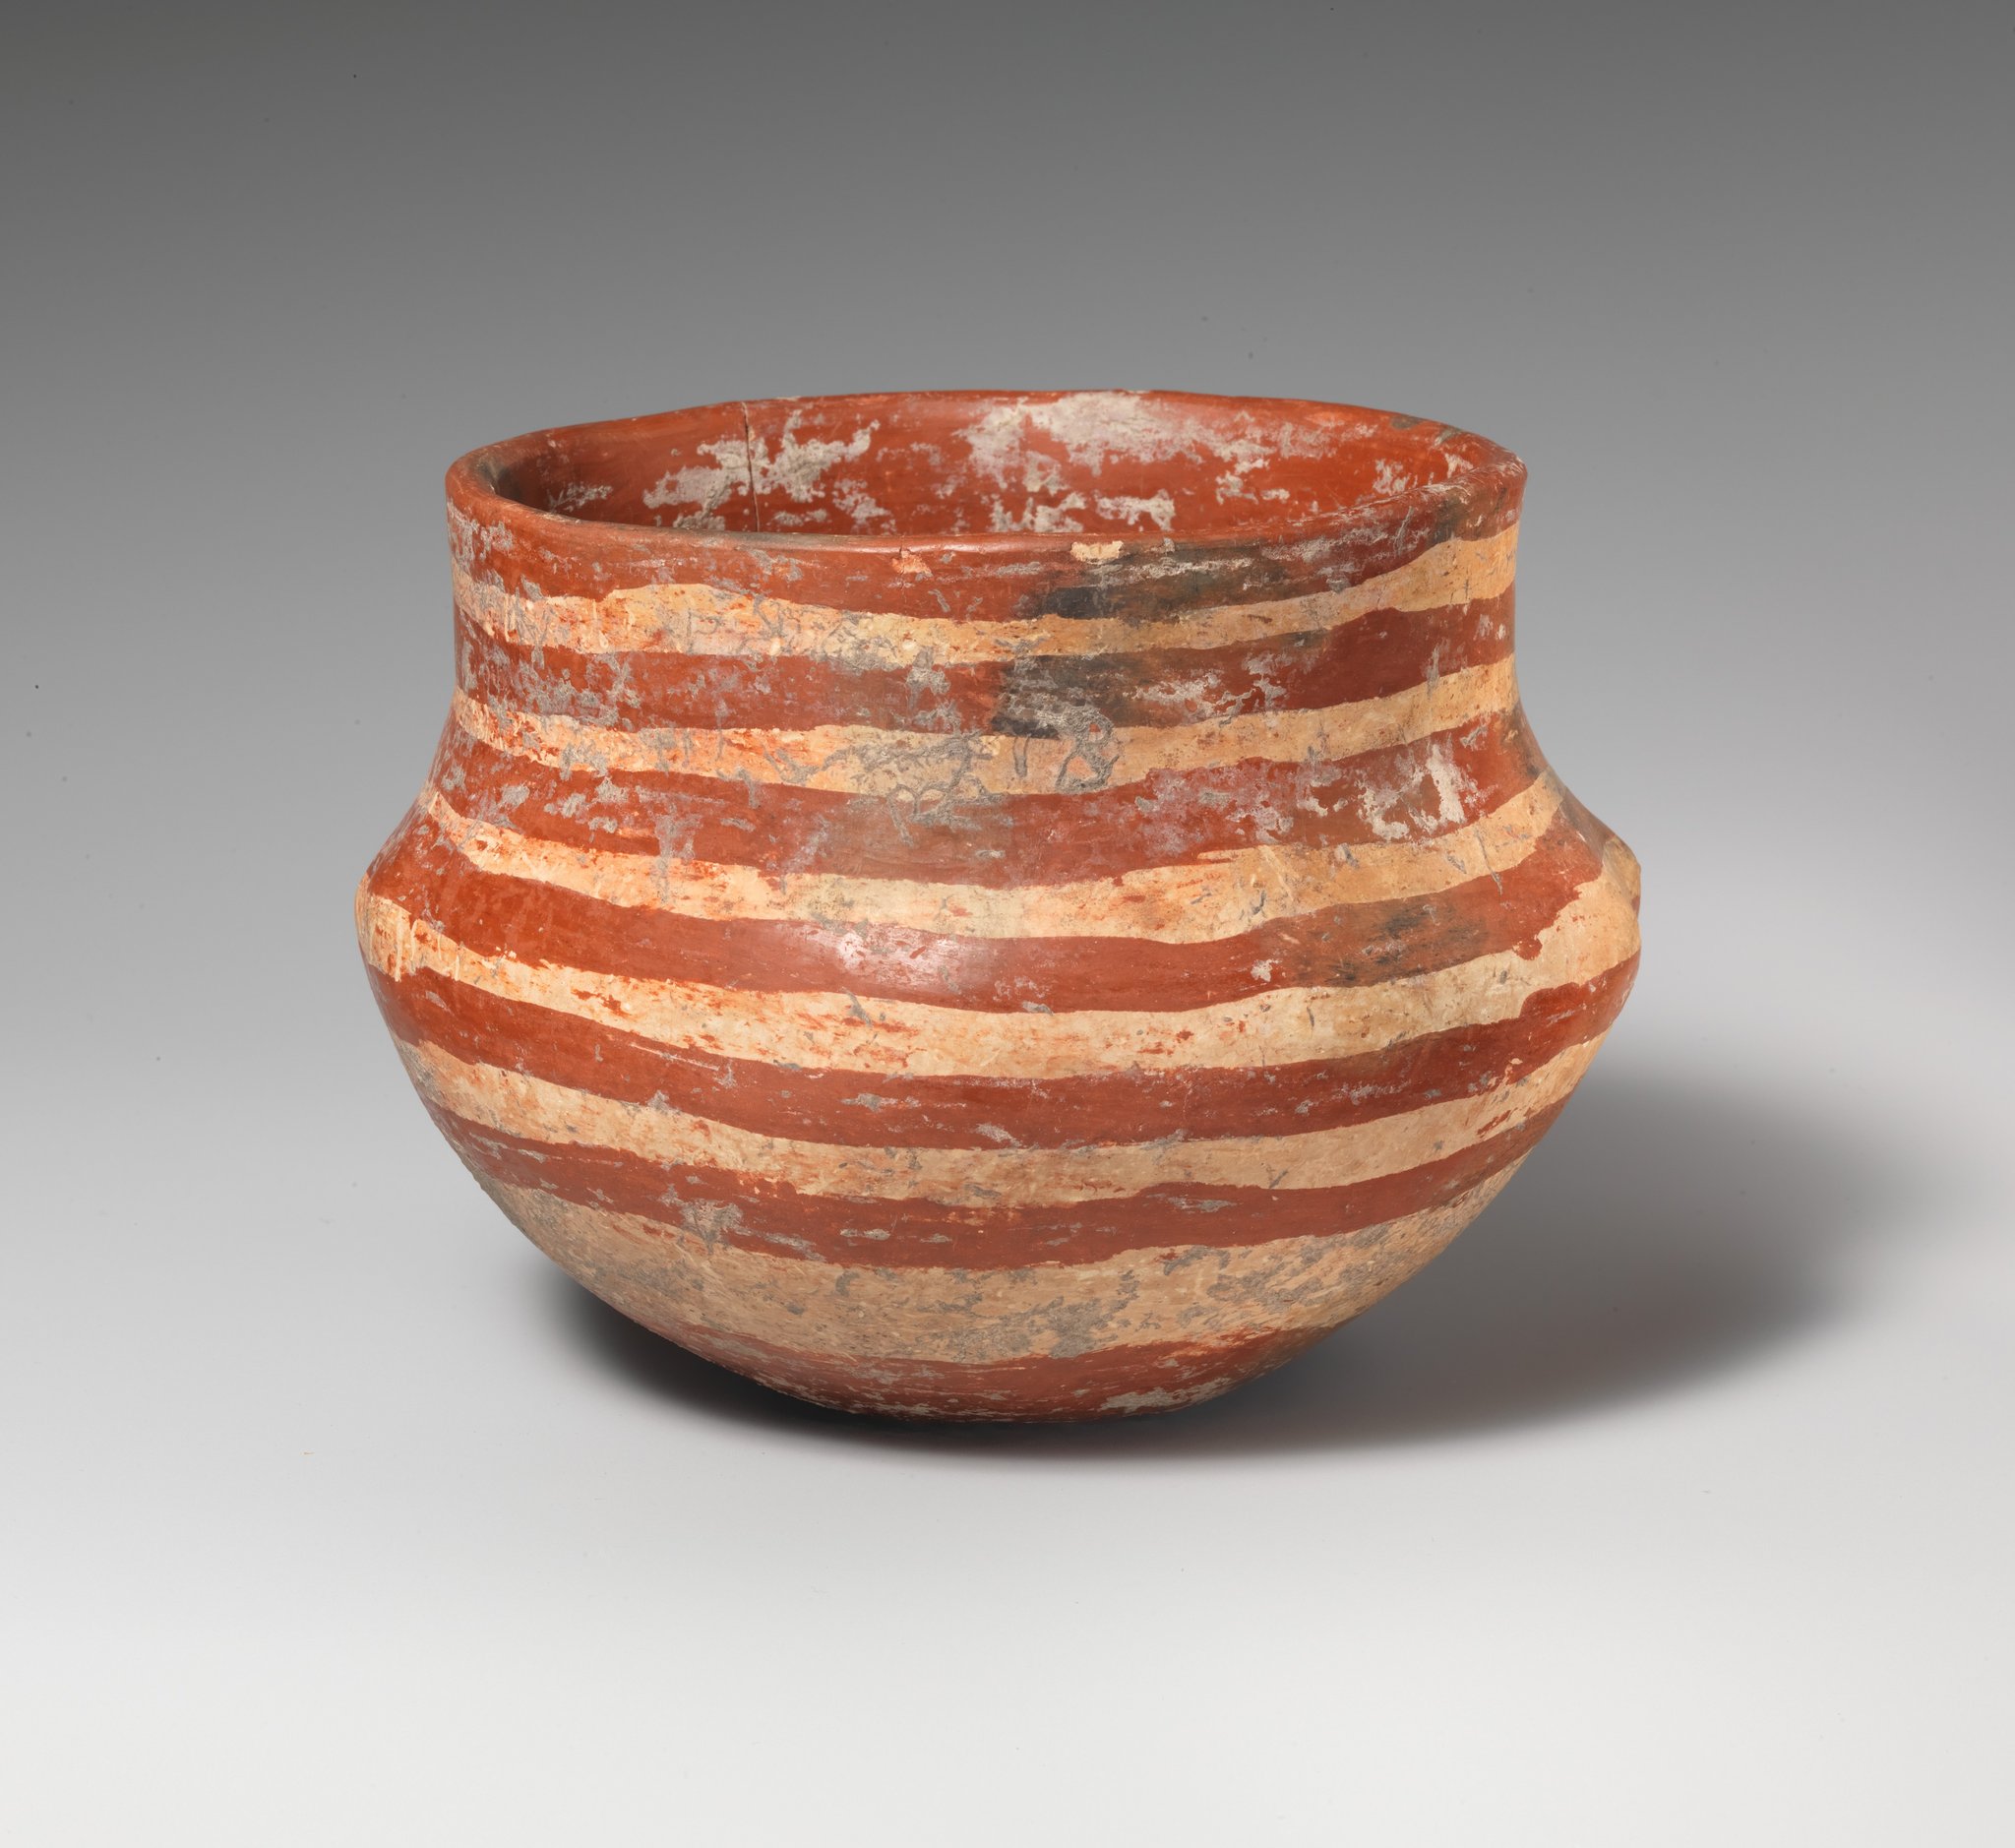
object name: jar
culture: hacilar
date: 5600-5400 BCE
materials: ceramic, paint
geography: southwestern anatolia